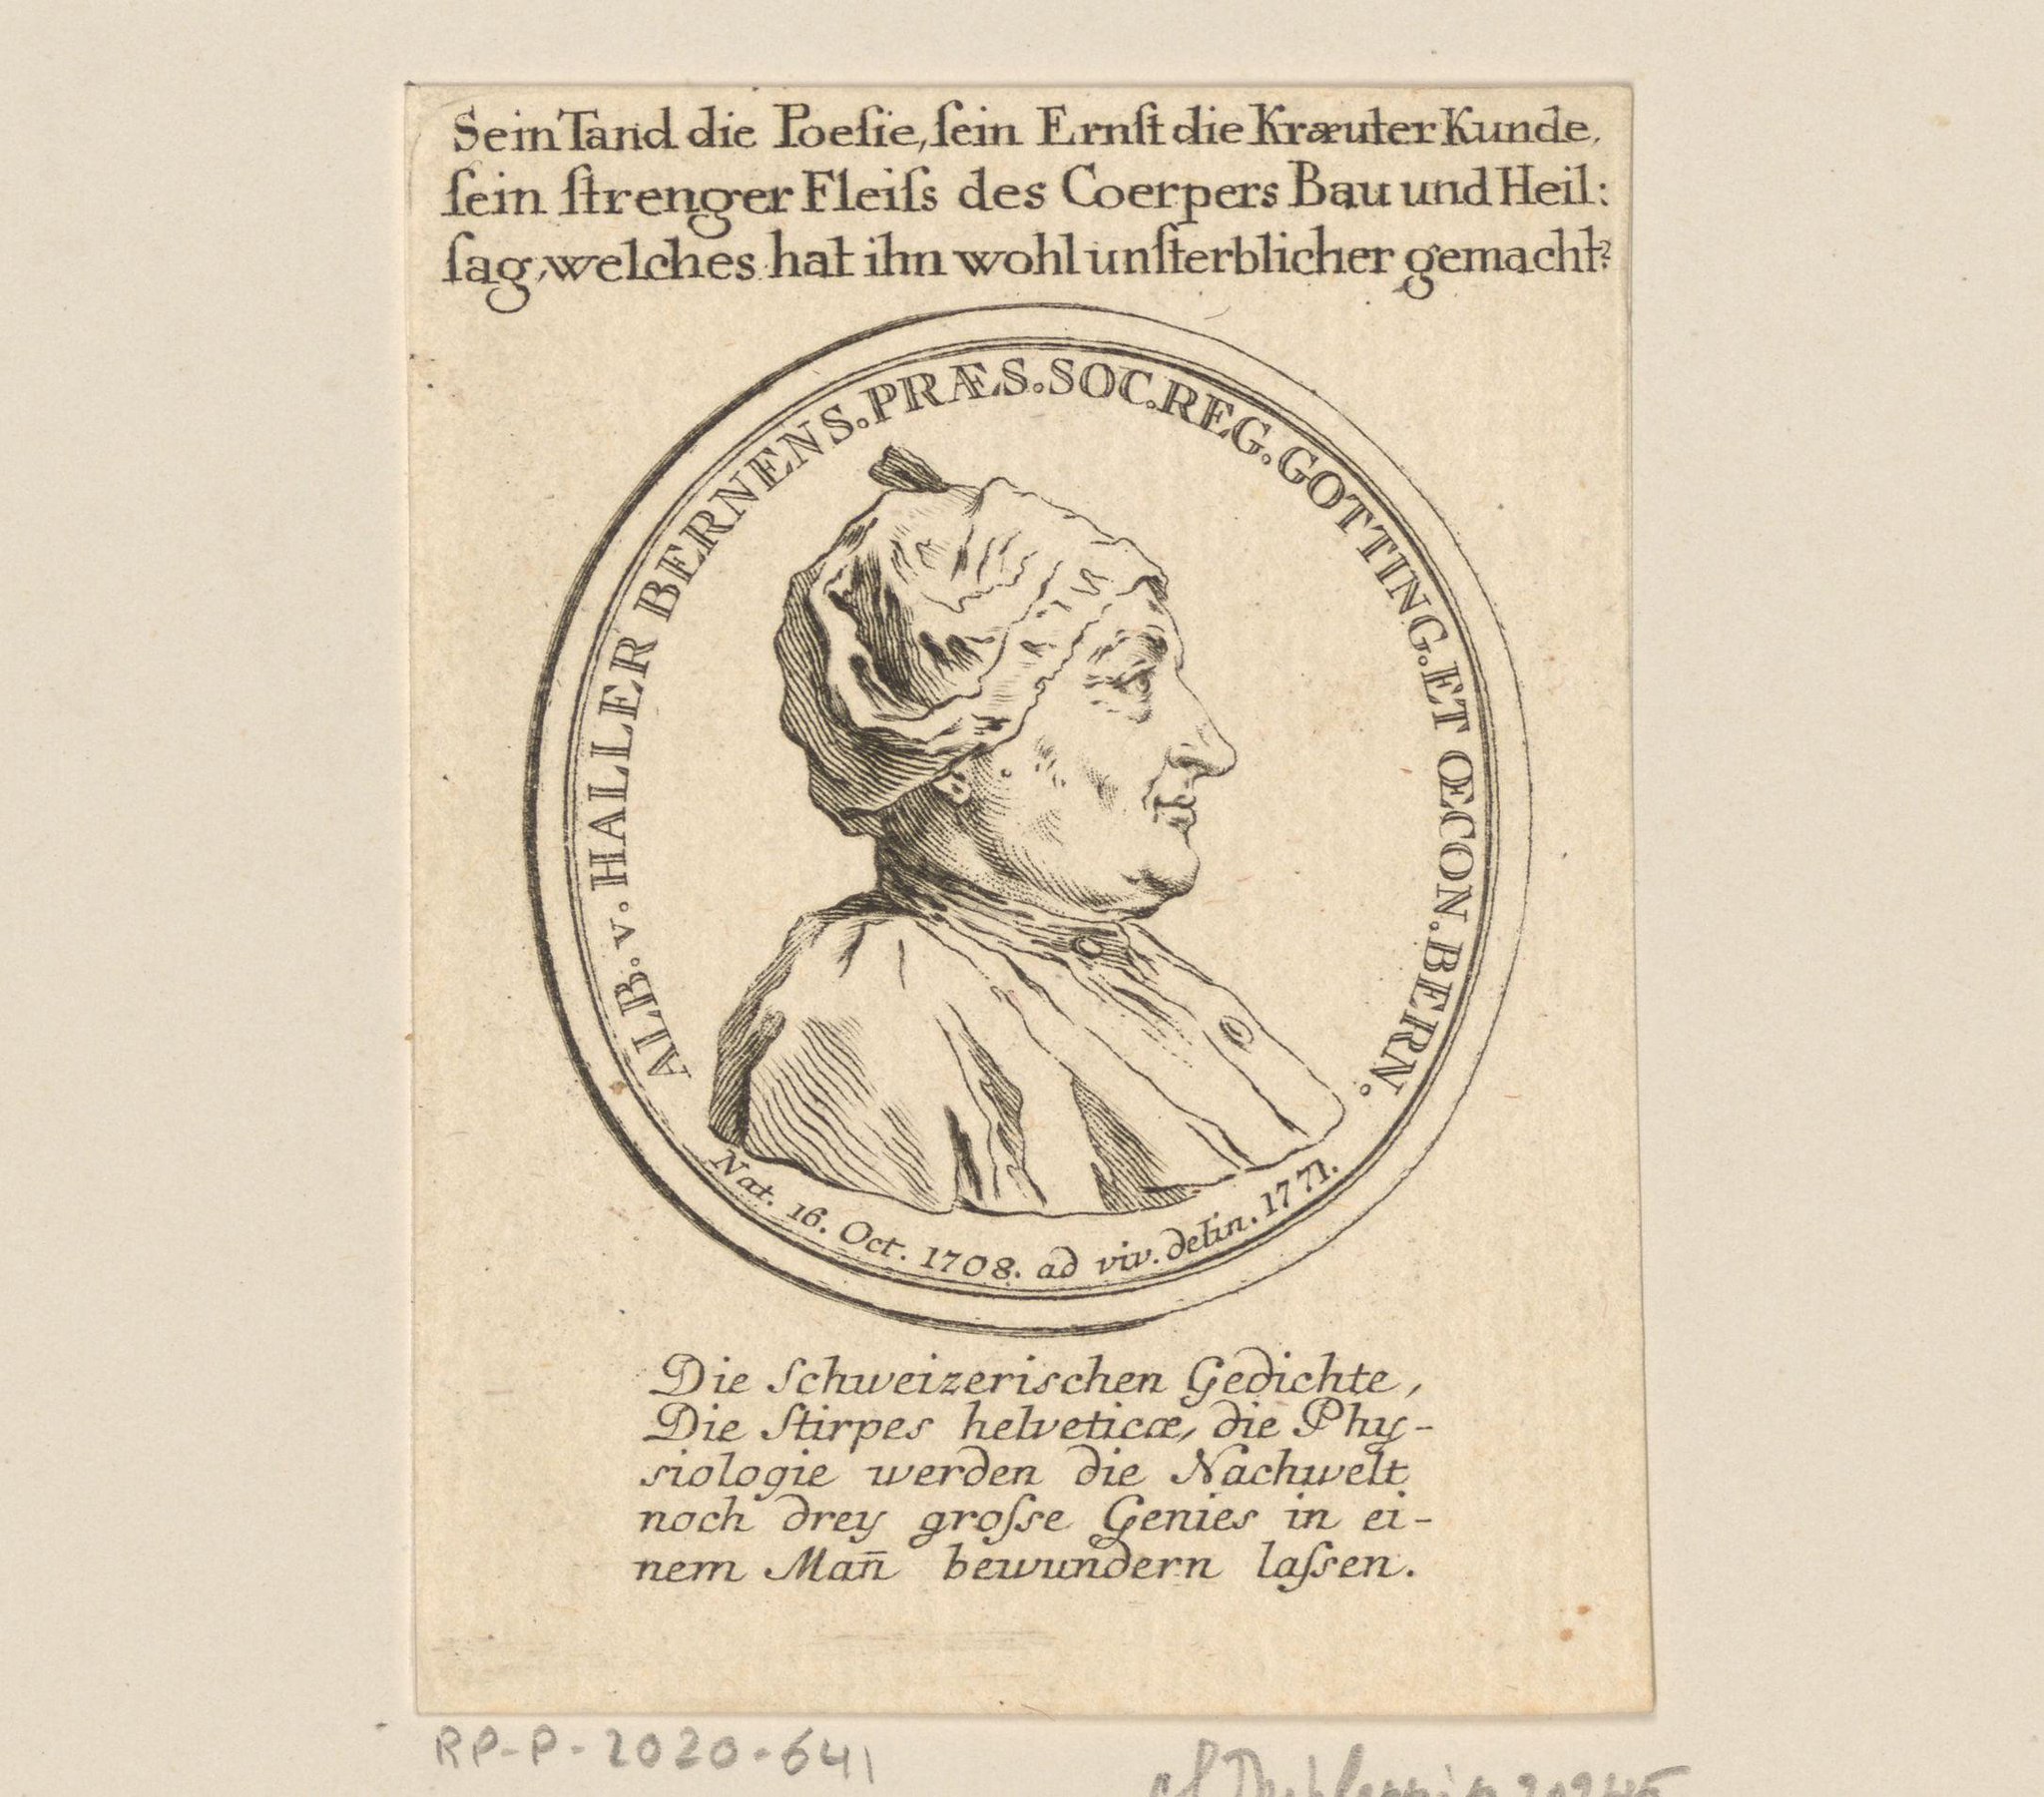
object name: print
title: Penning met portret van Albrecht von Haller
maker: Anonymous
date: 1771-1799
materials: paper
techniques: engraving, etching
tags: historical persons, physician, doctor, writer, poet, author